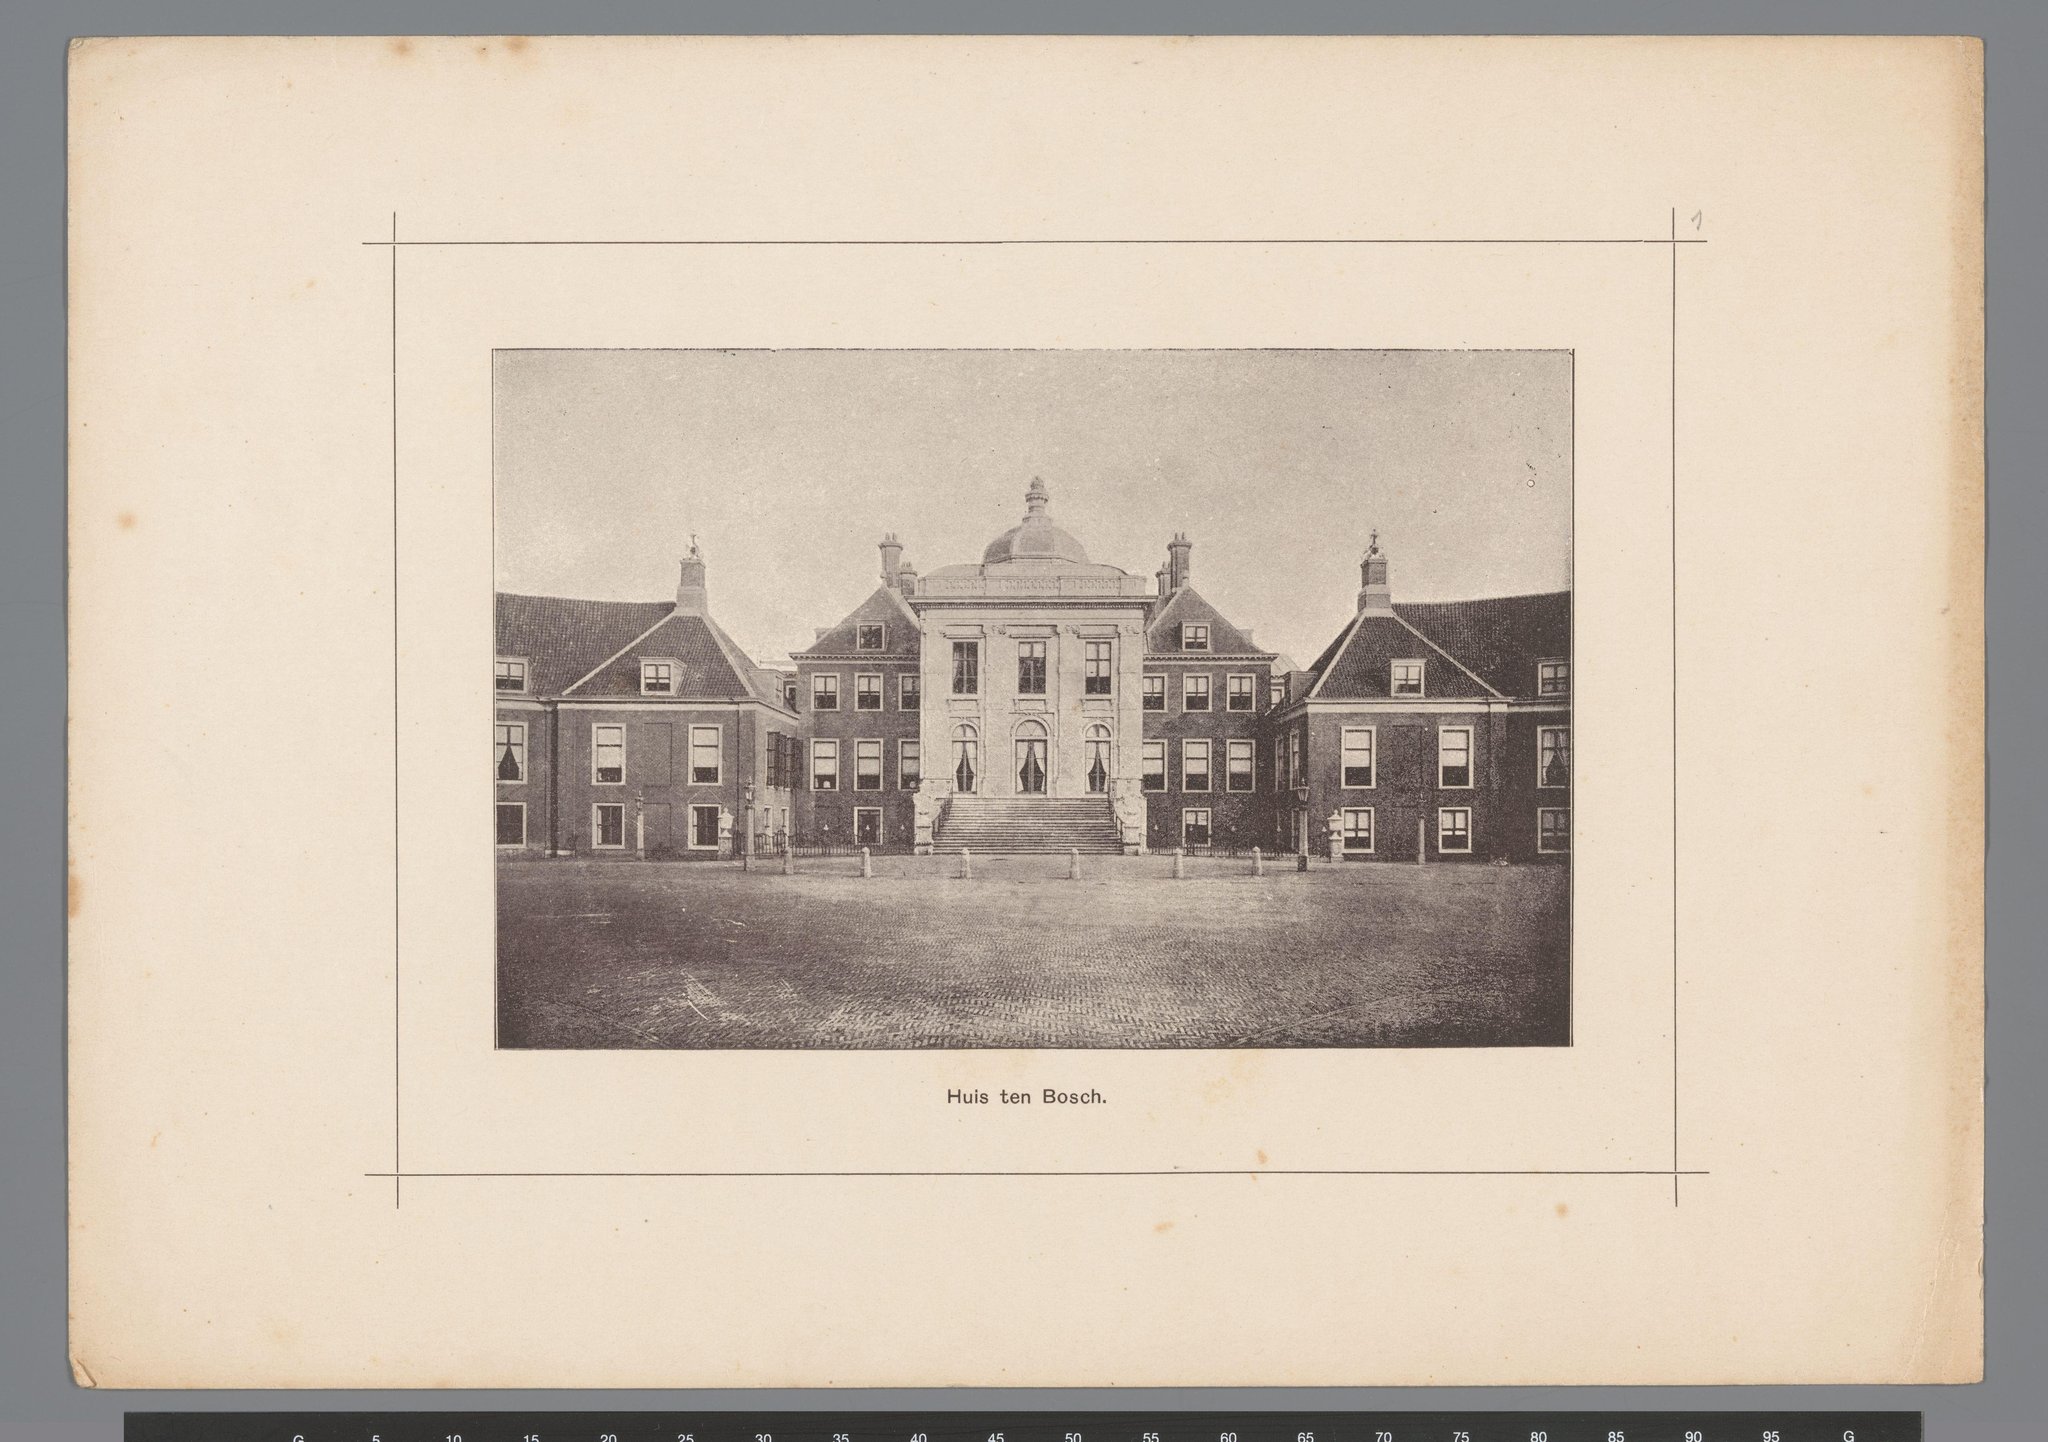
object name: photomechanical print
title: Huis ten Bosch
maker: Anonymous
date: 1880-1925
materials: paper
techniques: autotype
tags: palace, the hague